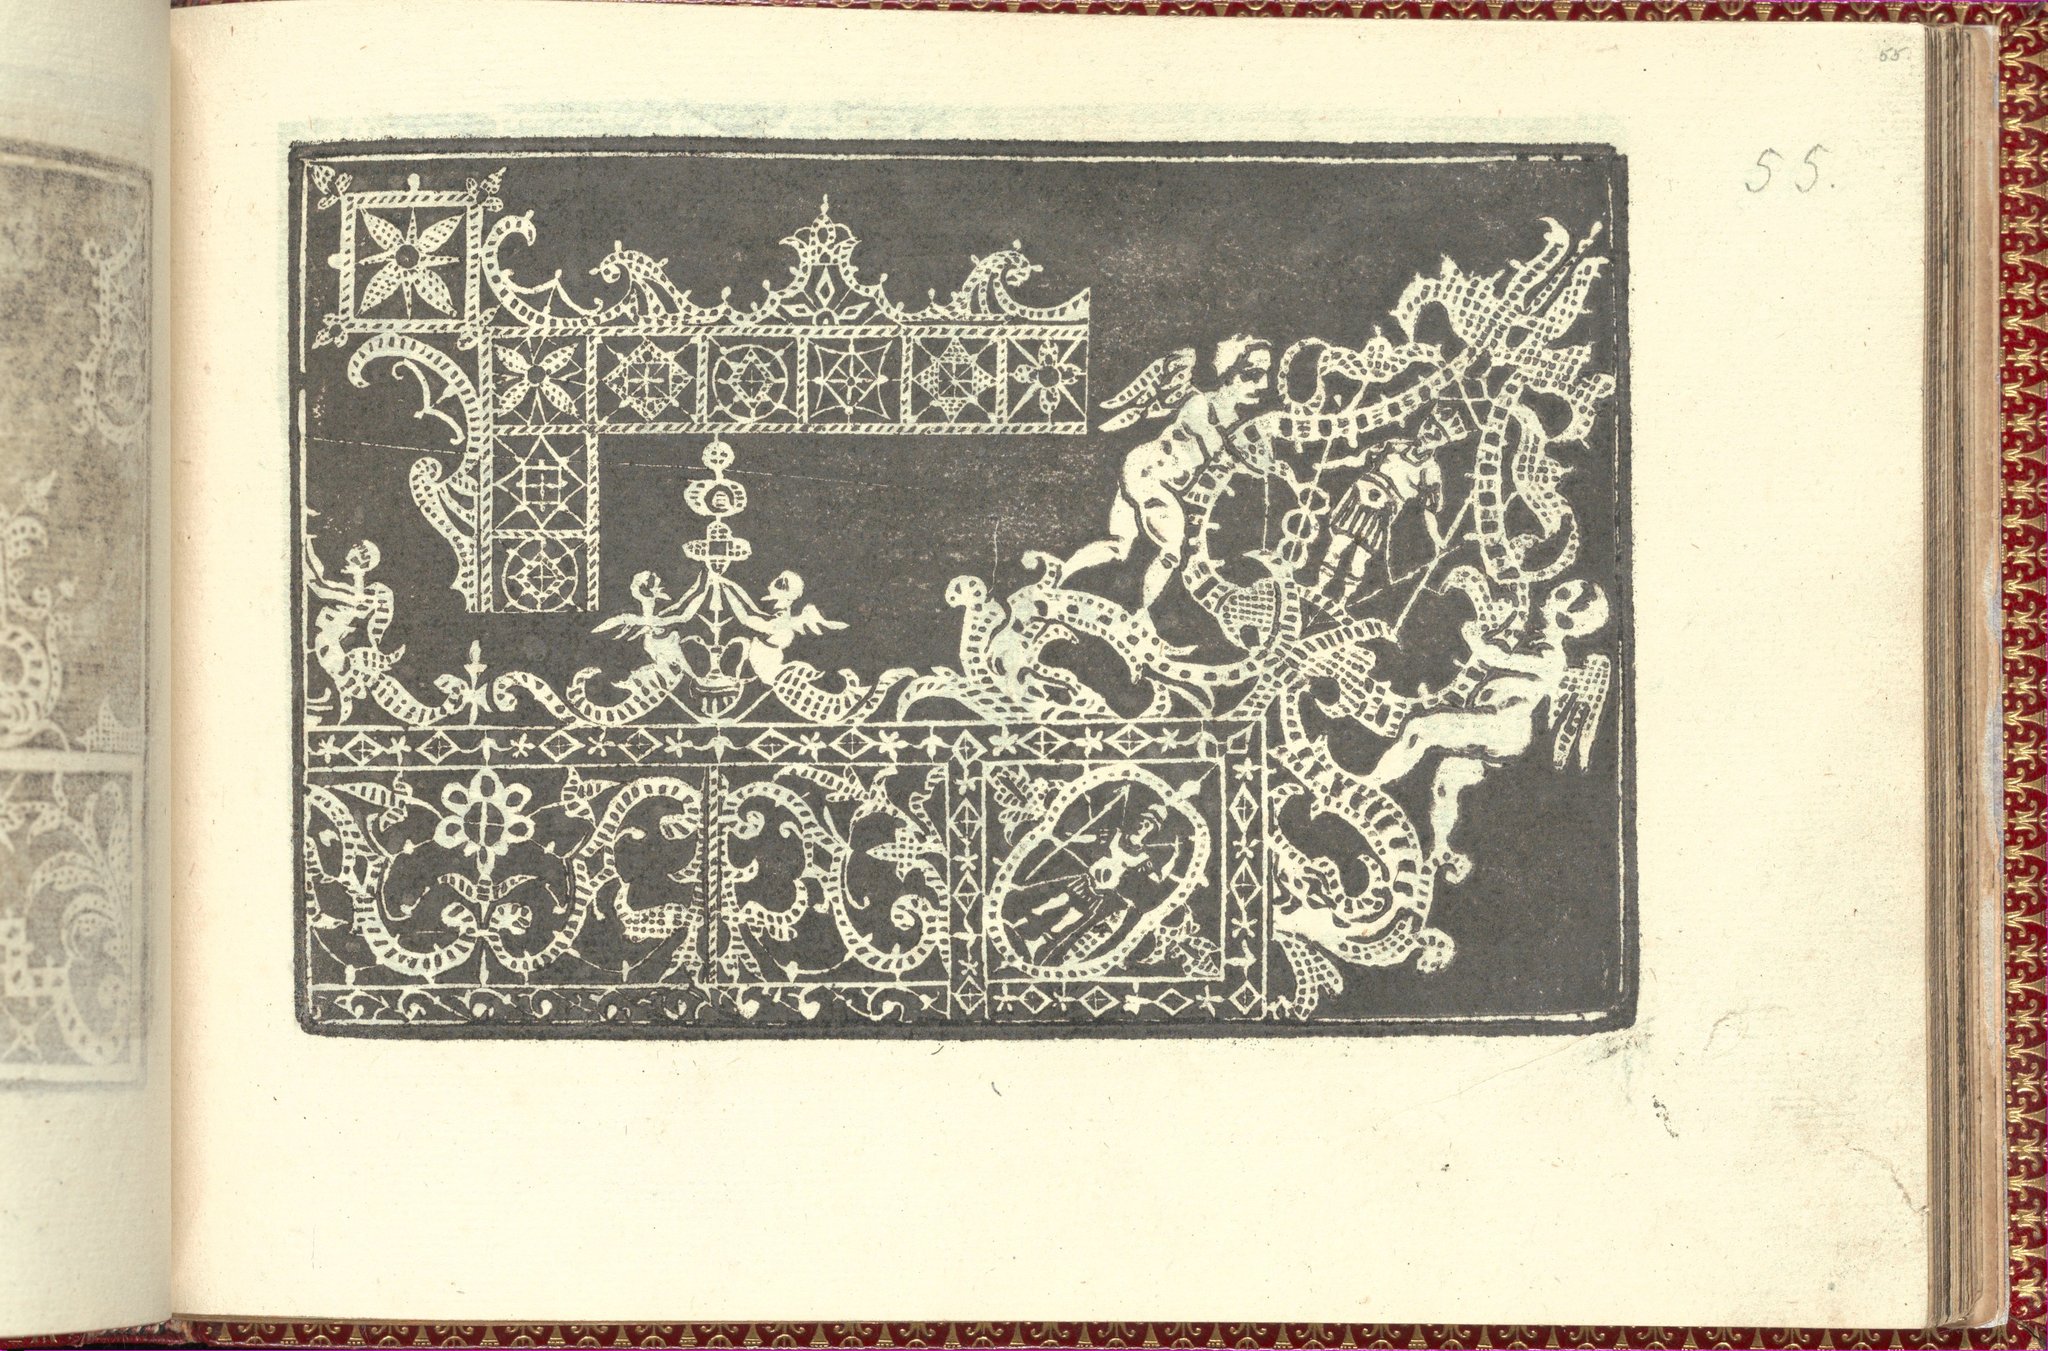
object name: book print ornament architecture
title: Corona delle Nobili et Virtuose Donne: Libro I-IV, page 55 (recto)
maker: cesare vecellio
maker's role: publisher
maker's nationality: italian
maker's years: 1521-1601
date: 1601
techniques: woodcut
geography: italy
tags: ornament